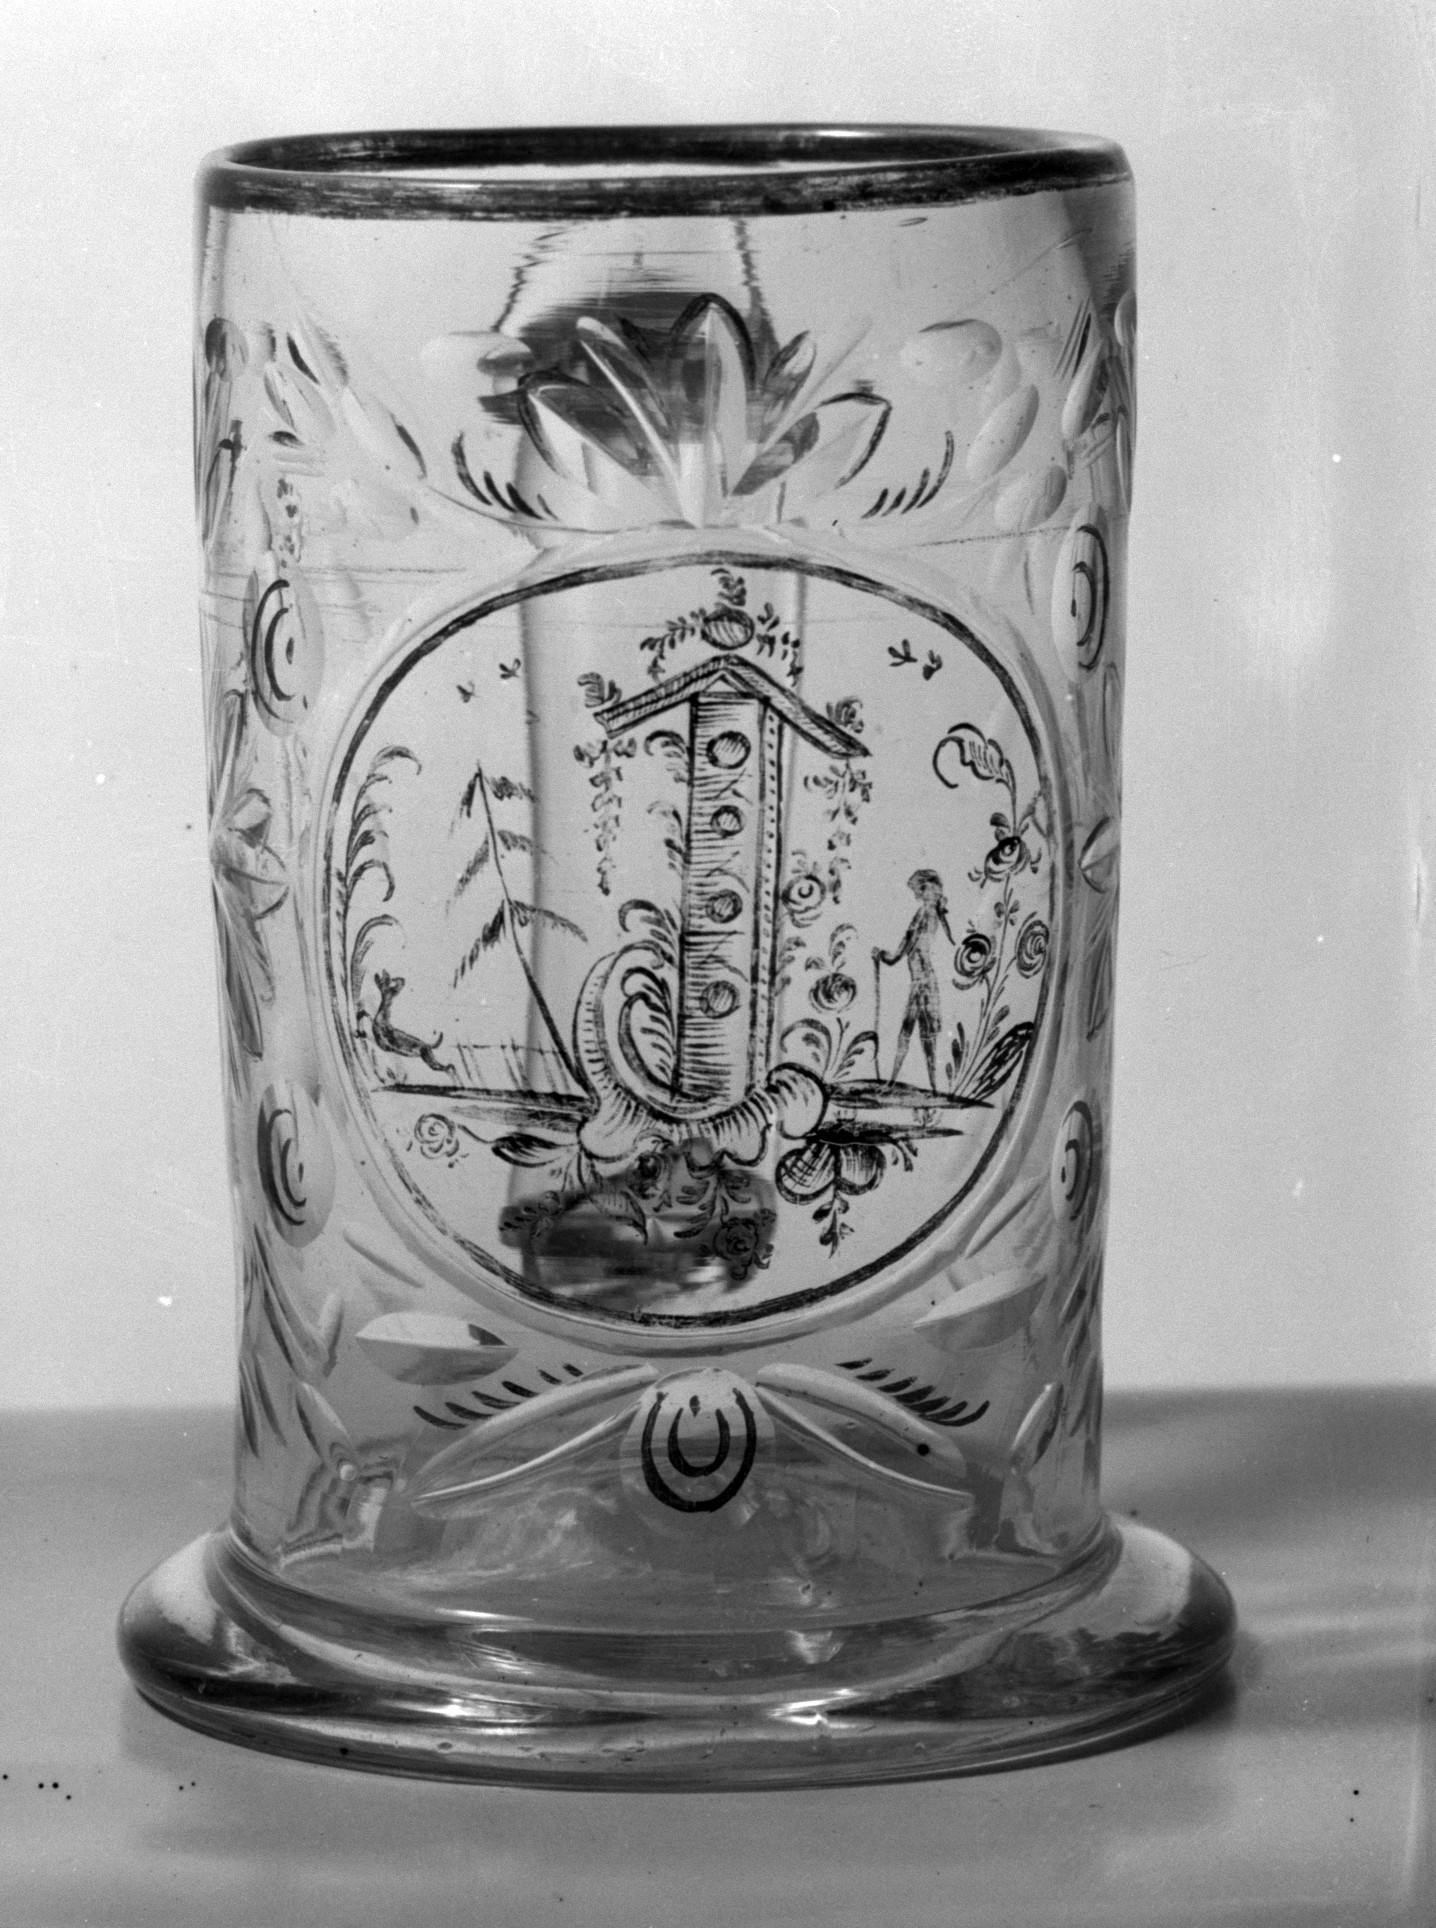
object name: mug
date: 1701-1800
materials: glass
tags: human figures,flowers